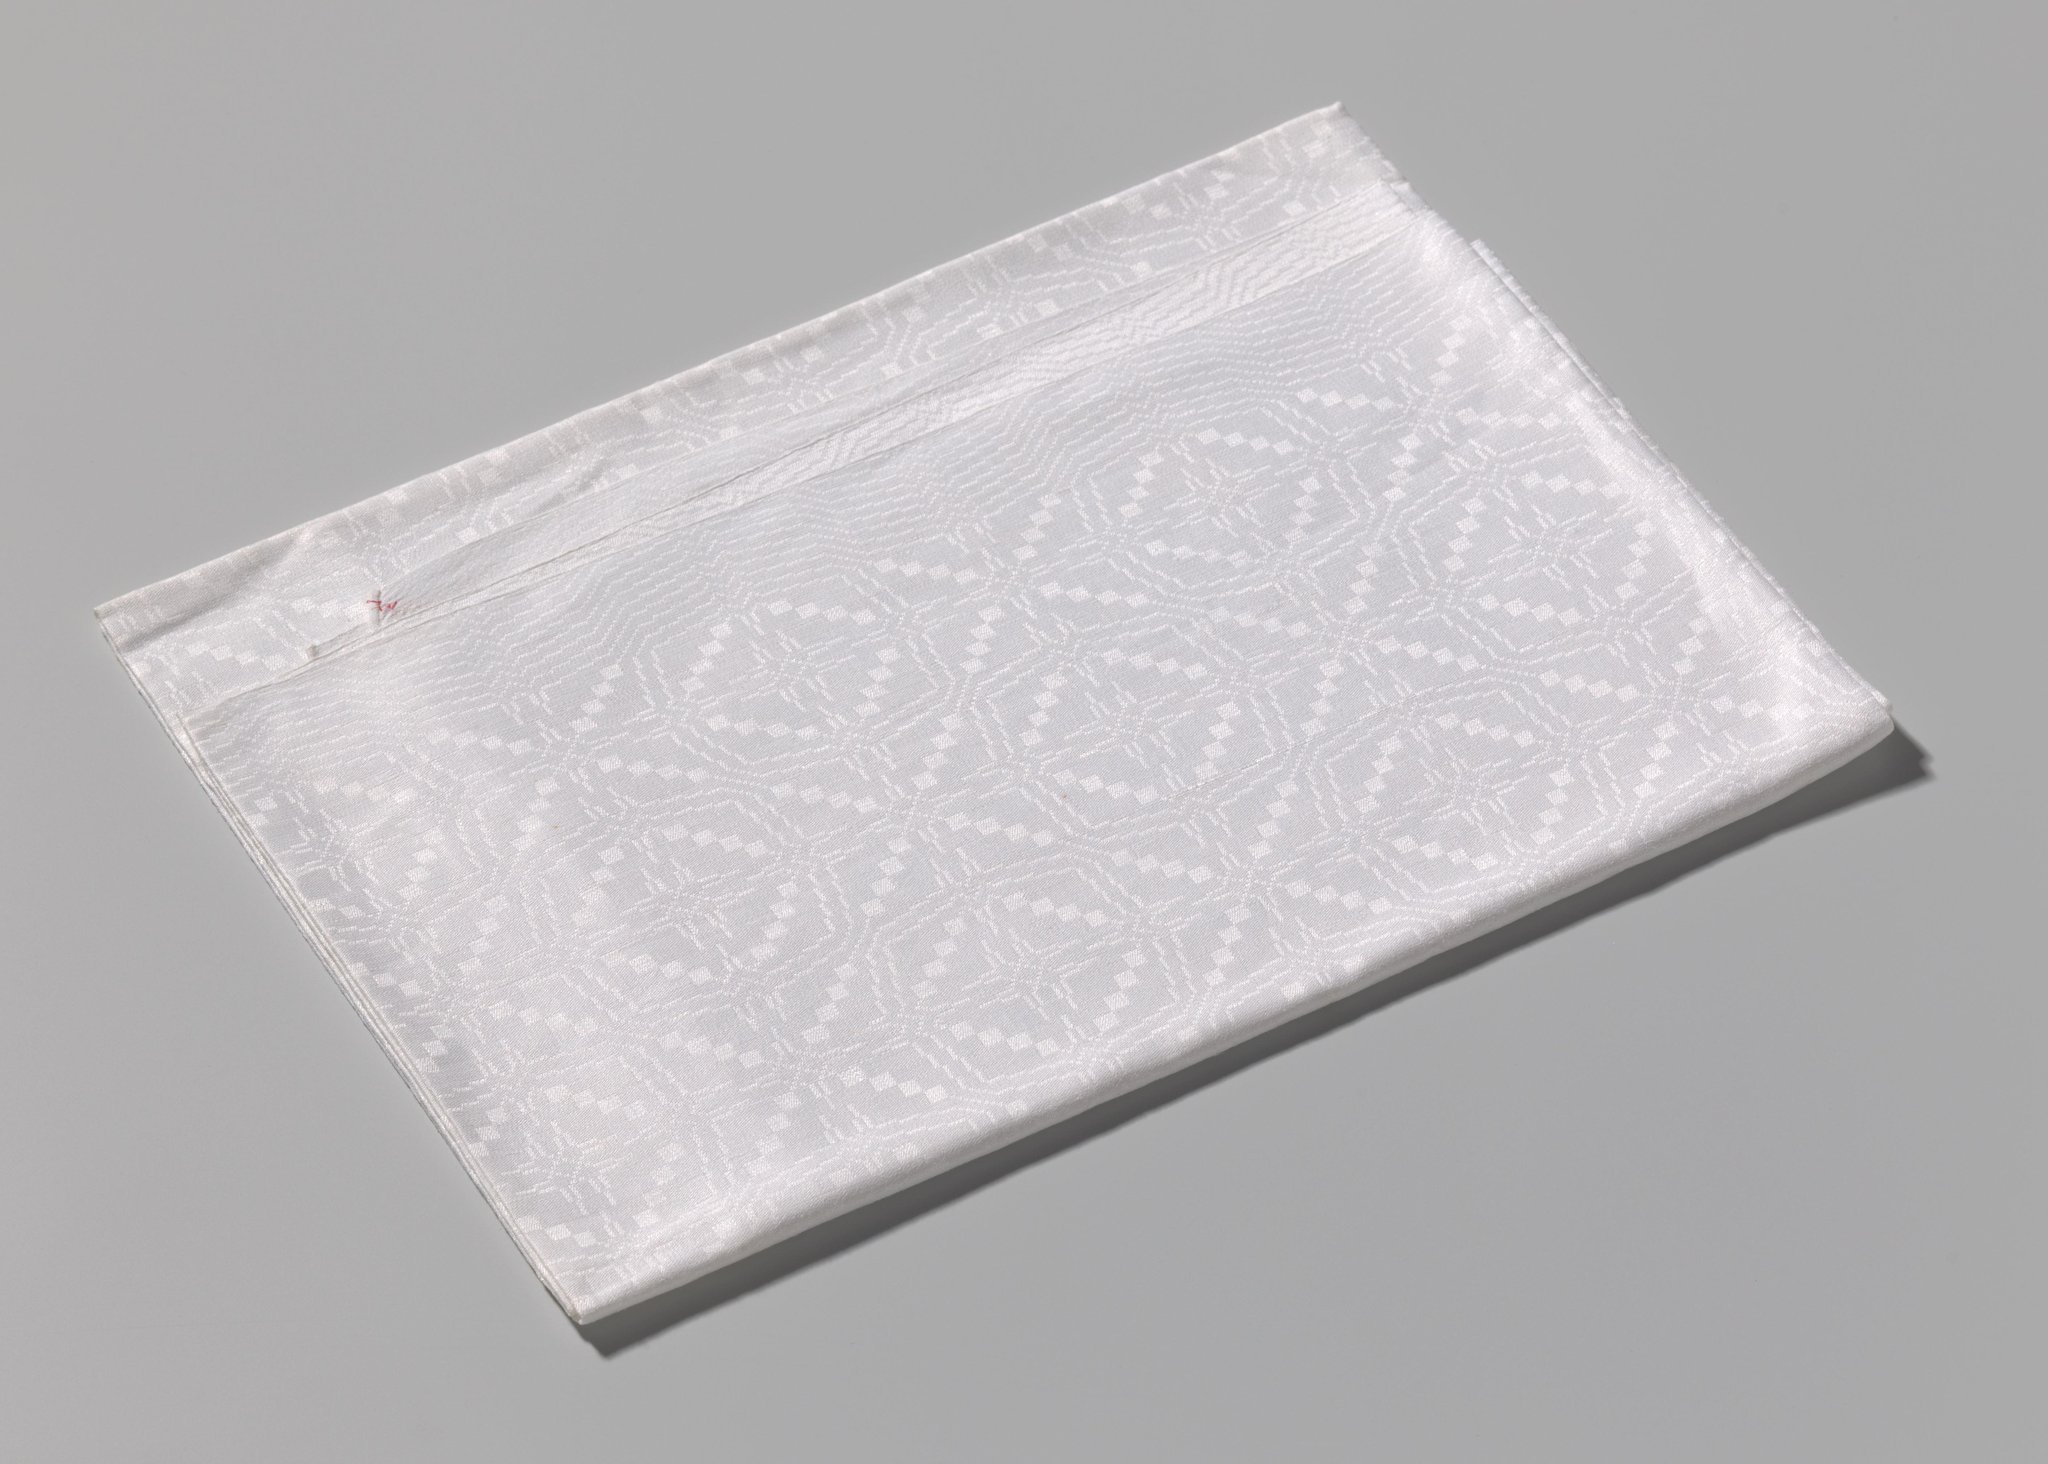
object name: napkin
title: Pellen. Merk: HW 38 p poonl.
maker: Anonymous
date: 1775-1799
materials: linen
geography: netherlands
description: Servet van wit linnen met een pellen patroon en randen, merk HW 38 p poonl.